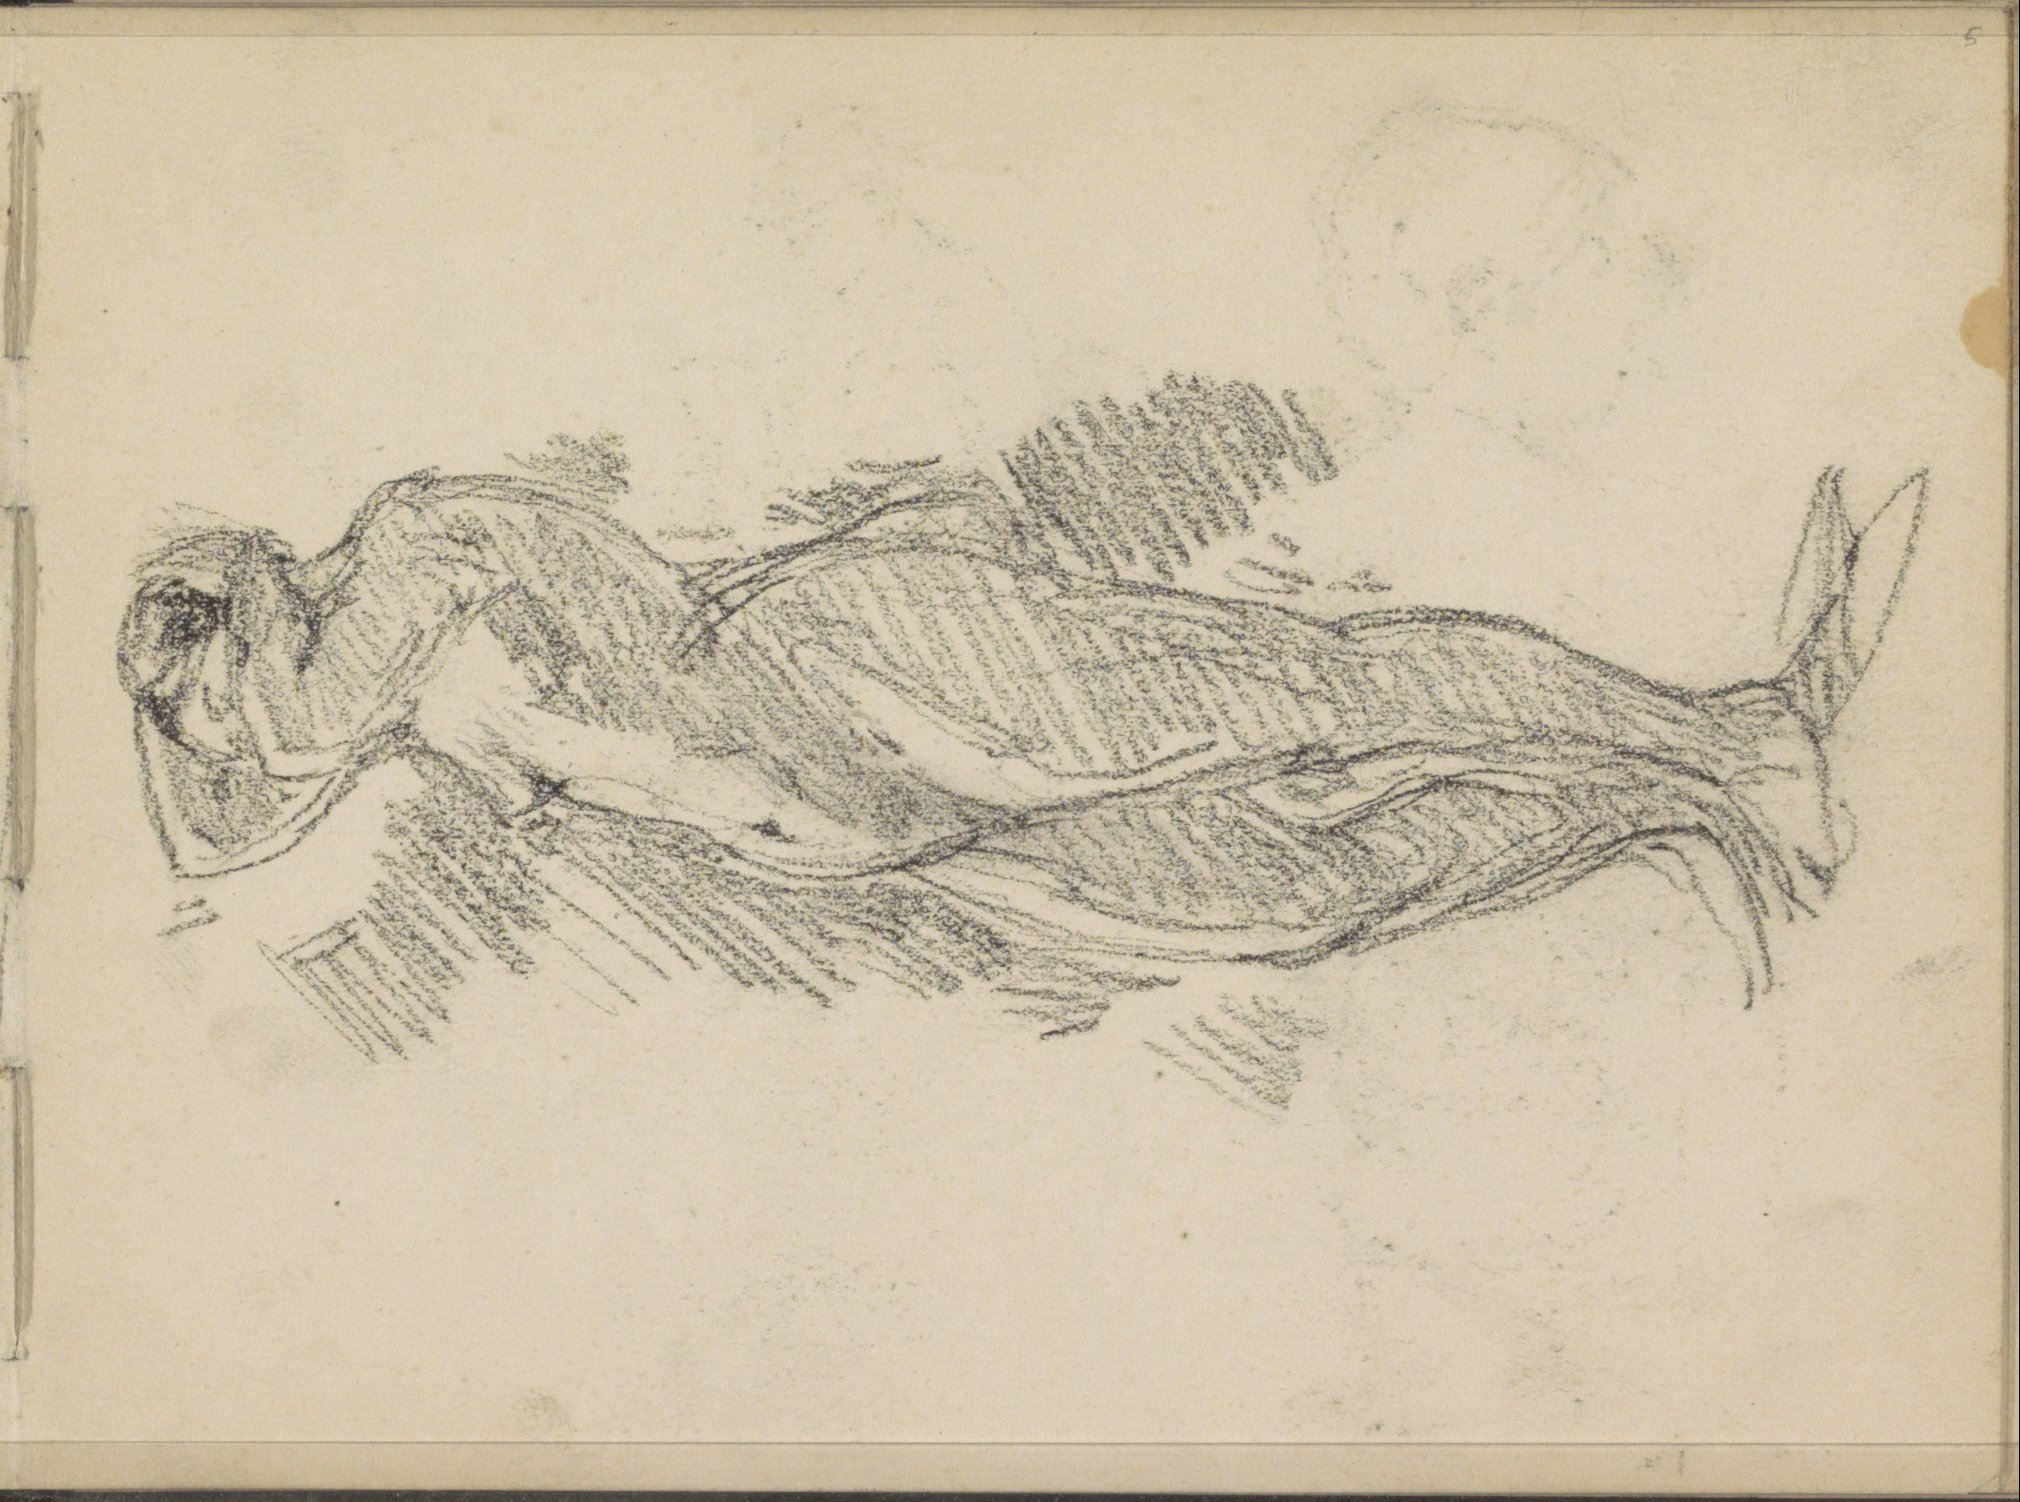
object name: sketchbook leaf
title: Vrouwelijk naakt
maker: marius bauer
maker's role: draughtsman, print maker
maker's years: 1867-1932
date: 1879-1884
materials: chalk, paper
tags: standing figure, the (nude) human figure; 'corpo humano' (ripa) - aa - female human figure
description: De vrouw is van opzij en ten voeten uit getekend met de armen opgeheven. Pagina 5 uit een schetsboek met 28 bladen.